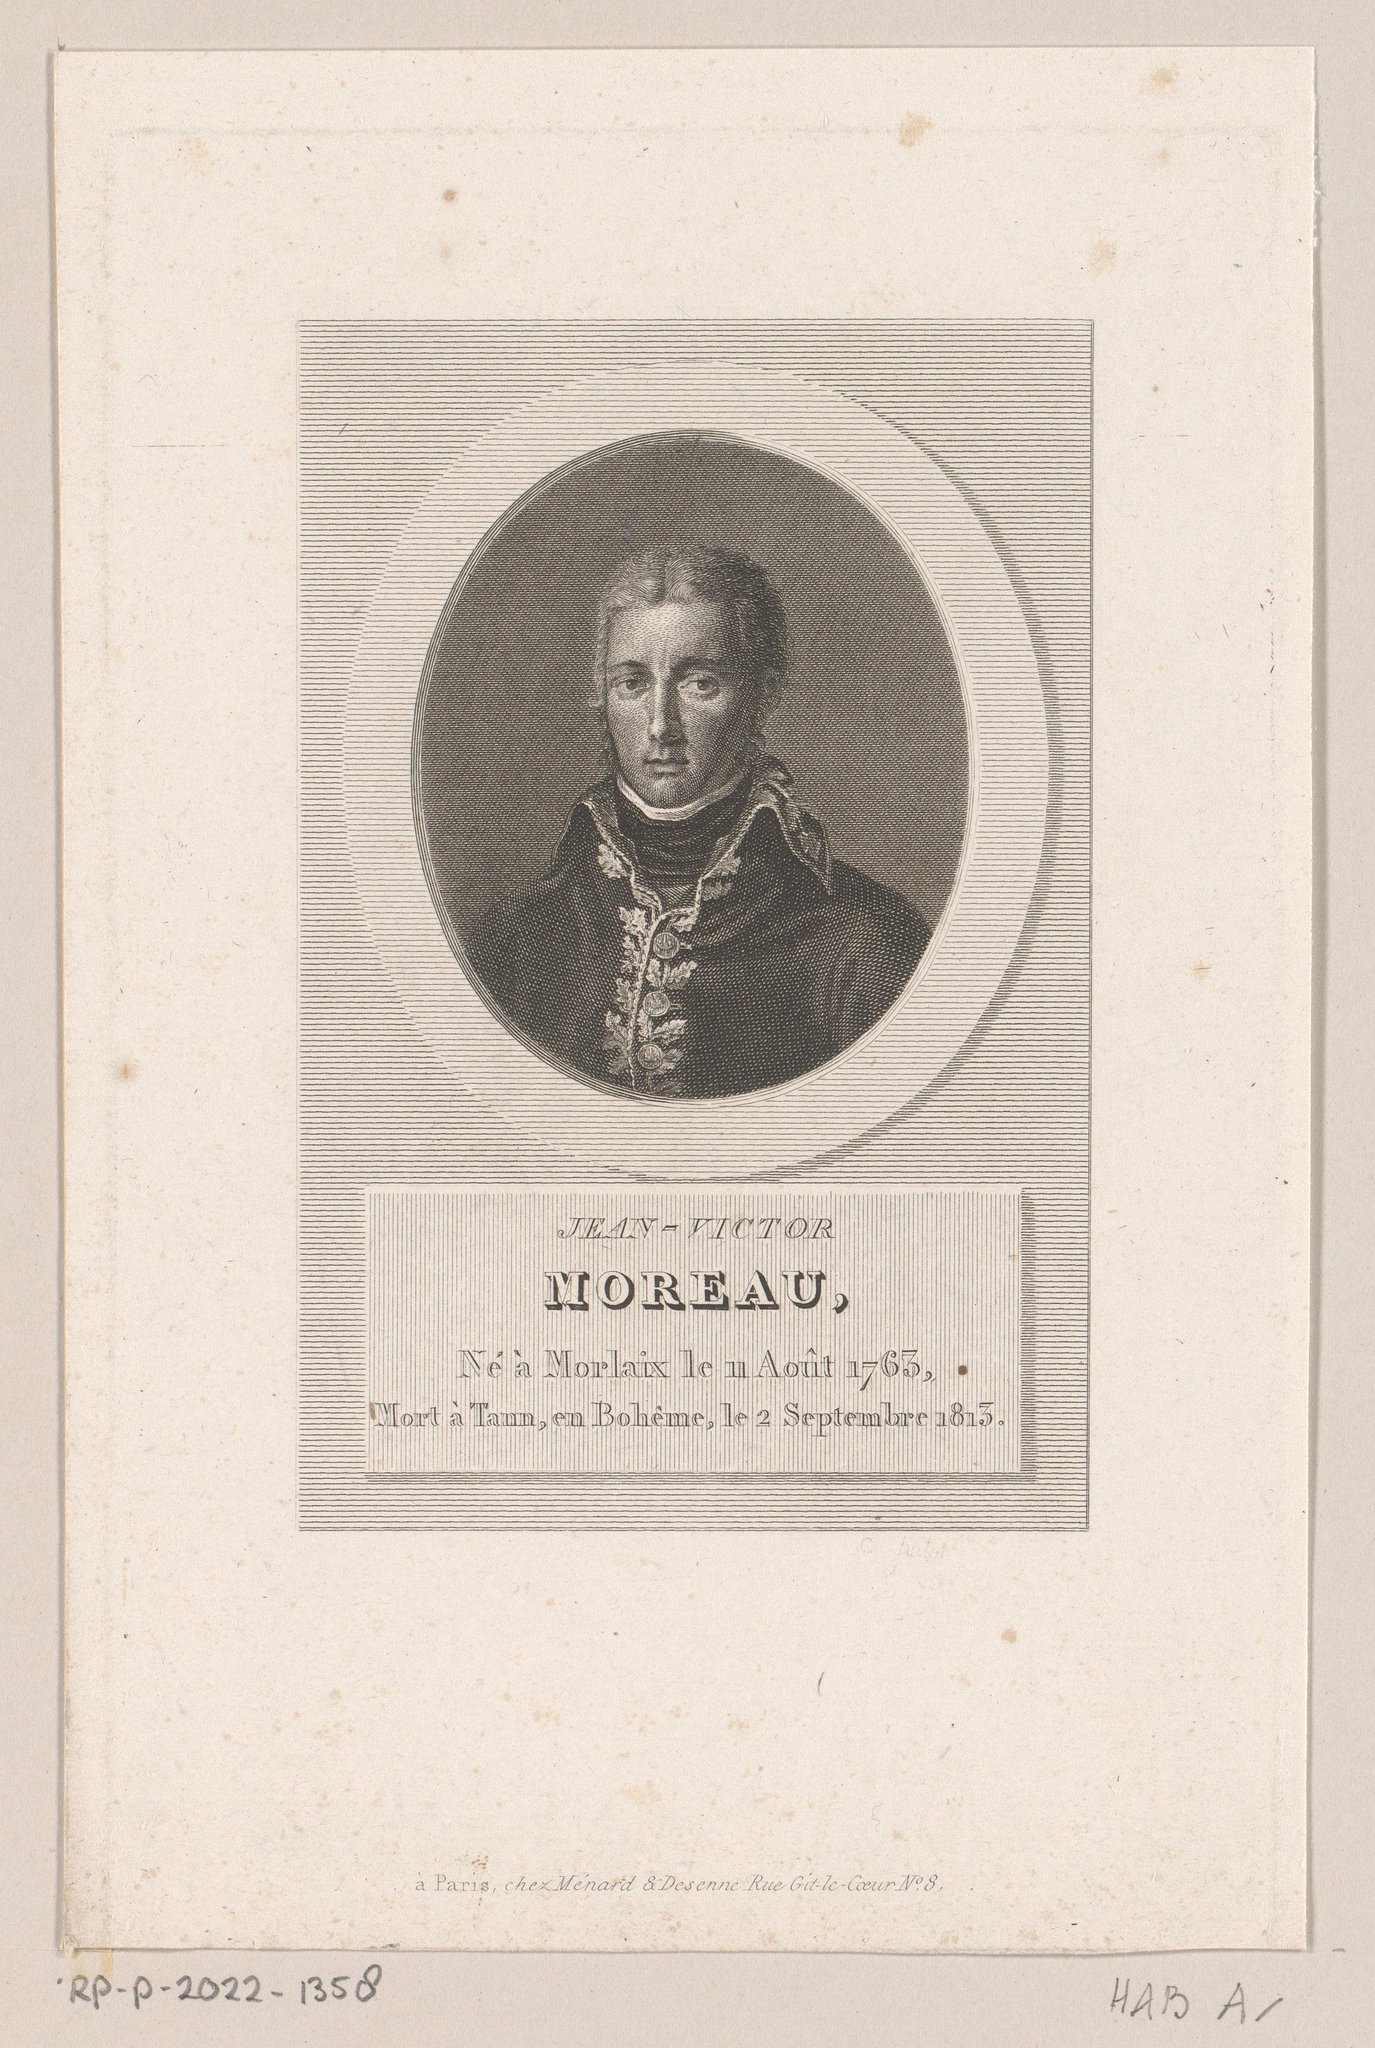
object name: print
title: Jean-Victor Moreau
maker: Anonymous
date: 1816-1831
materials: paper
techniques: engraving, etching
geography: paris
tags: commander-in-chief, general, marshal, historical persons